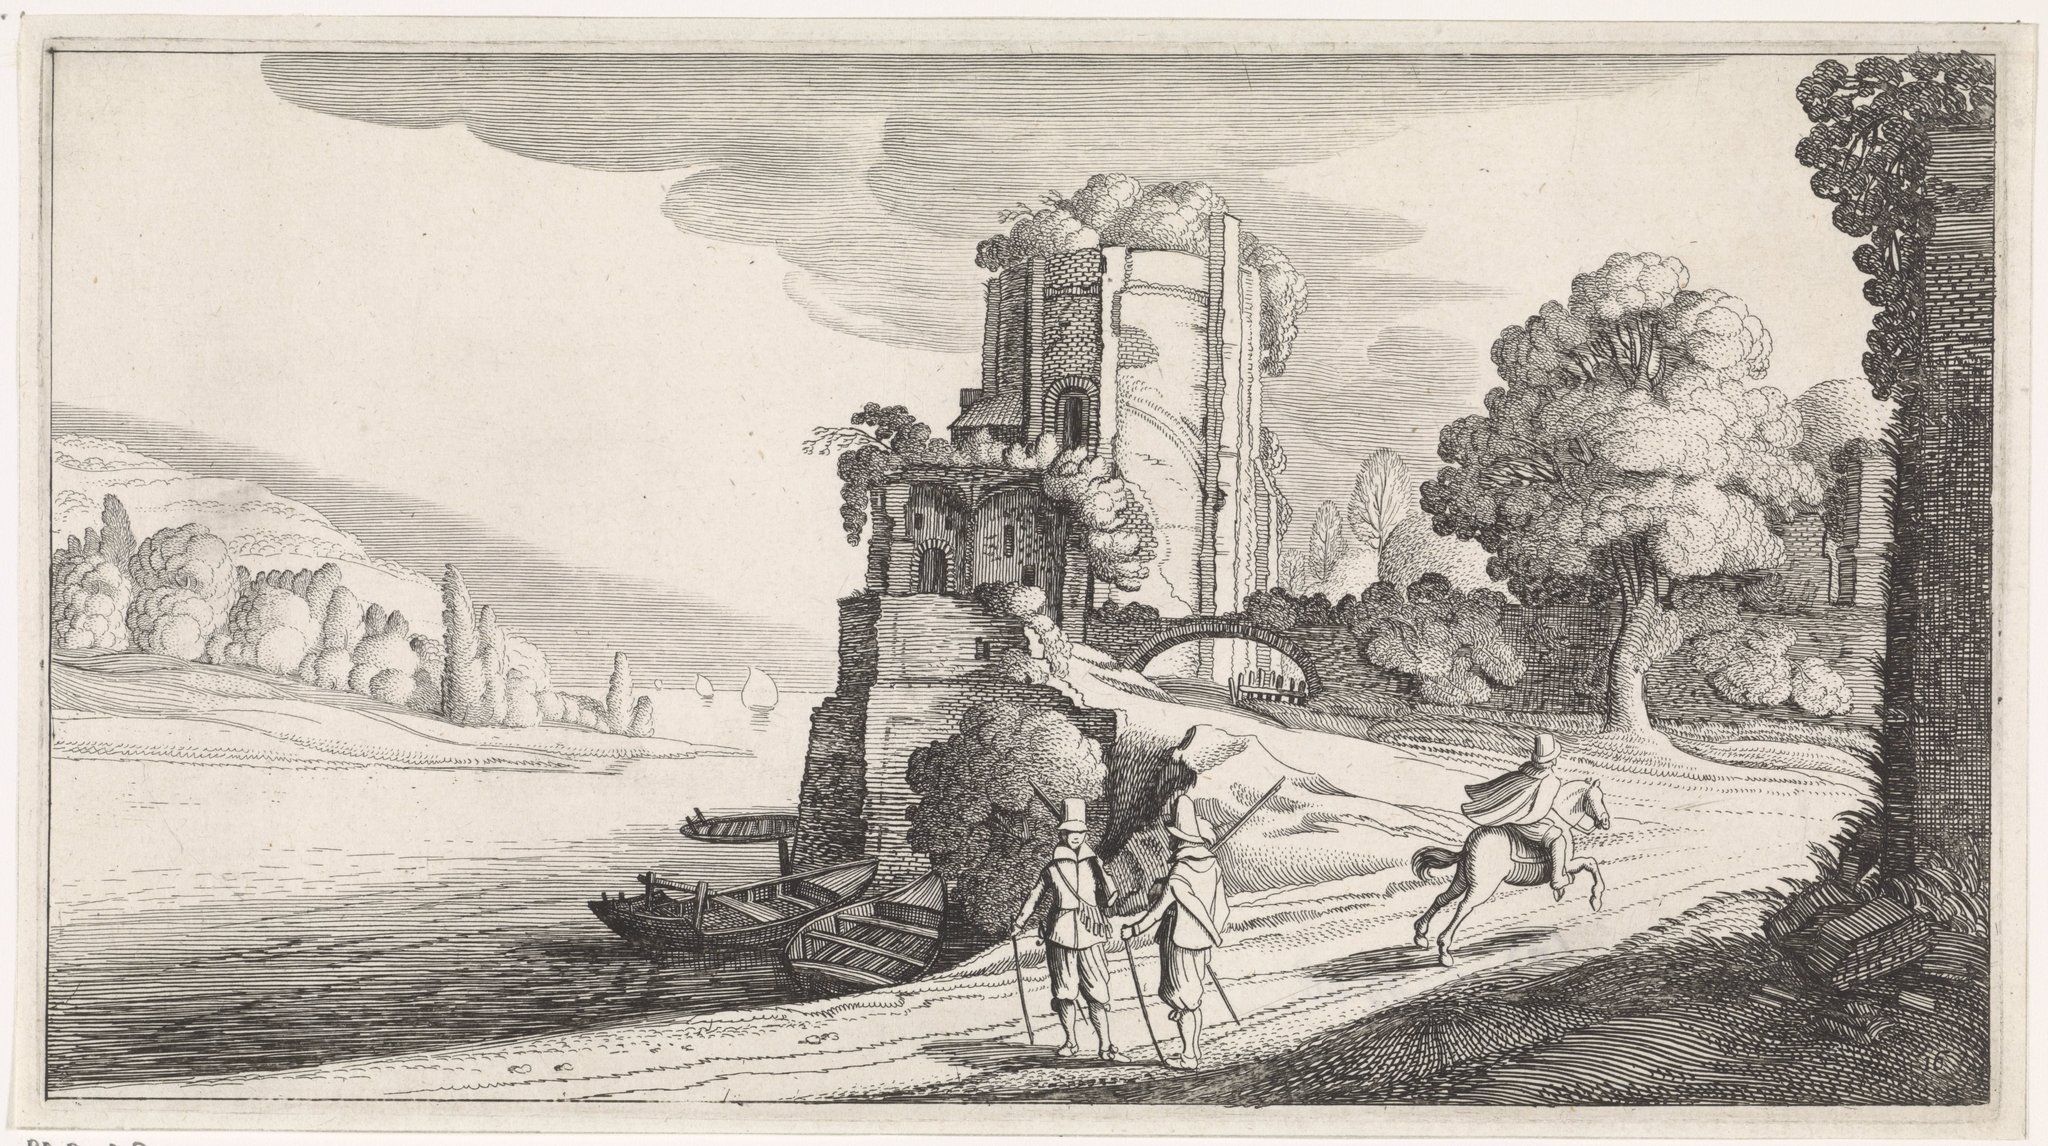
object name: print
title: Playsante lantschappen ende vermakelycke gesichten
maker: jan van de velde (ii)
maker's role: draughtsman, painter, print maker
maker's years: 1593-1641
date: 1639-1641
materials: paper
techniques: etching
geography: northern netherlands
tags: riding a horse, ass, or mule; rider, horseman, river, landscape with tower or castle, galloping horse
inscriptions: collector's mark: Lugt 964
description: Twee converserende heren op een pad en een galopperende ruiter bij een ronde toren in een rivierlandschap. Aan de horizon zeilschepen. Zestiende prent van een serie met 36 prenten van landschappen, verdeeld over zes delen.